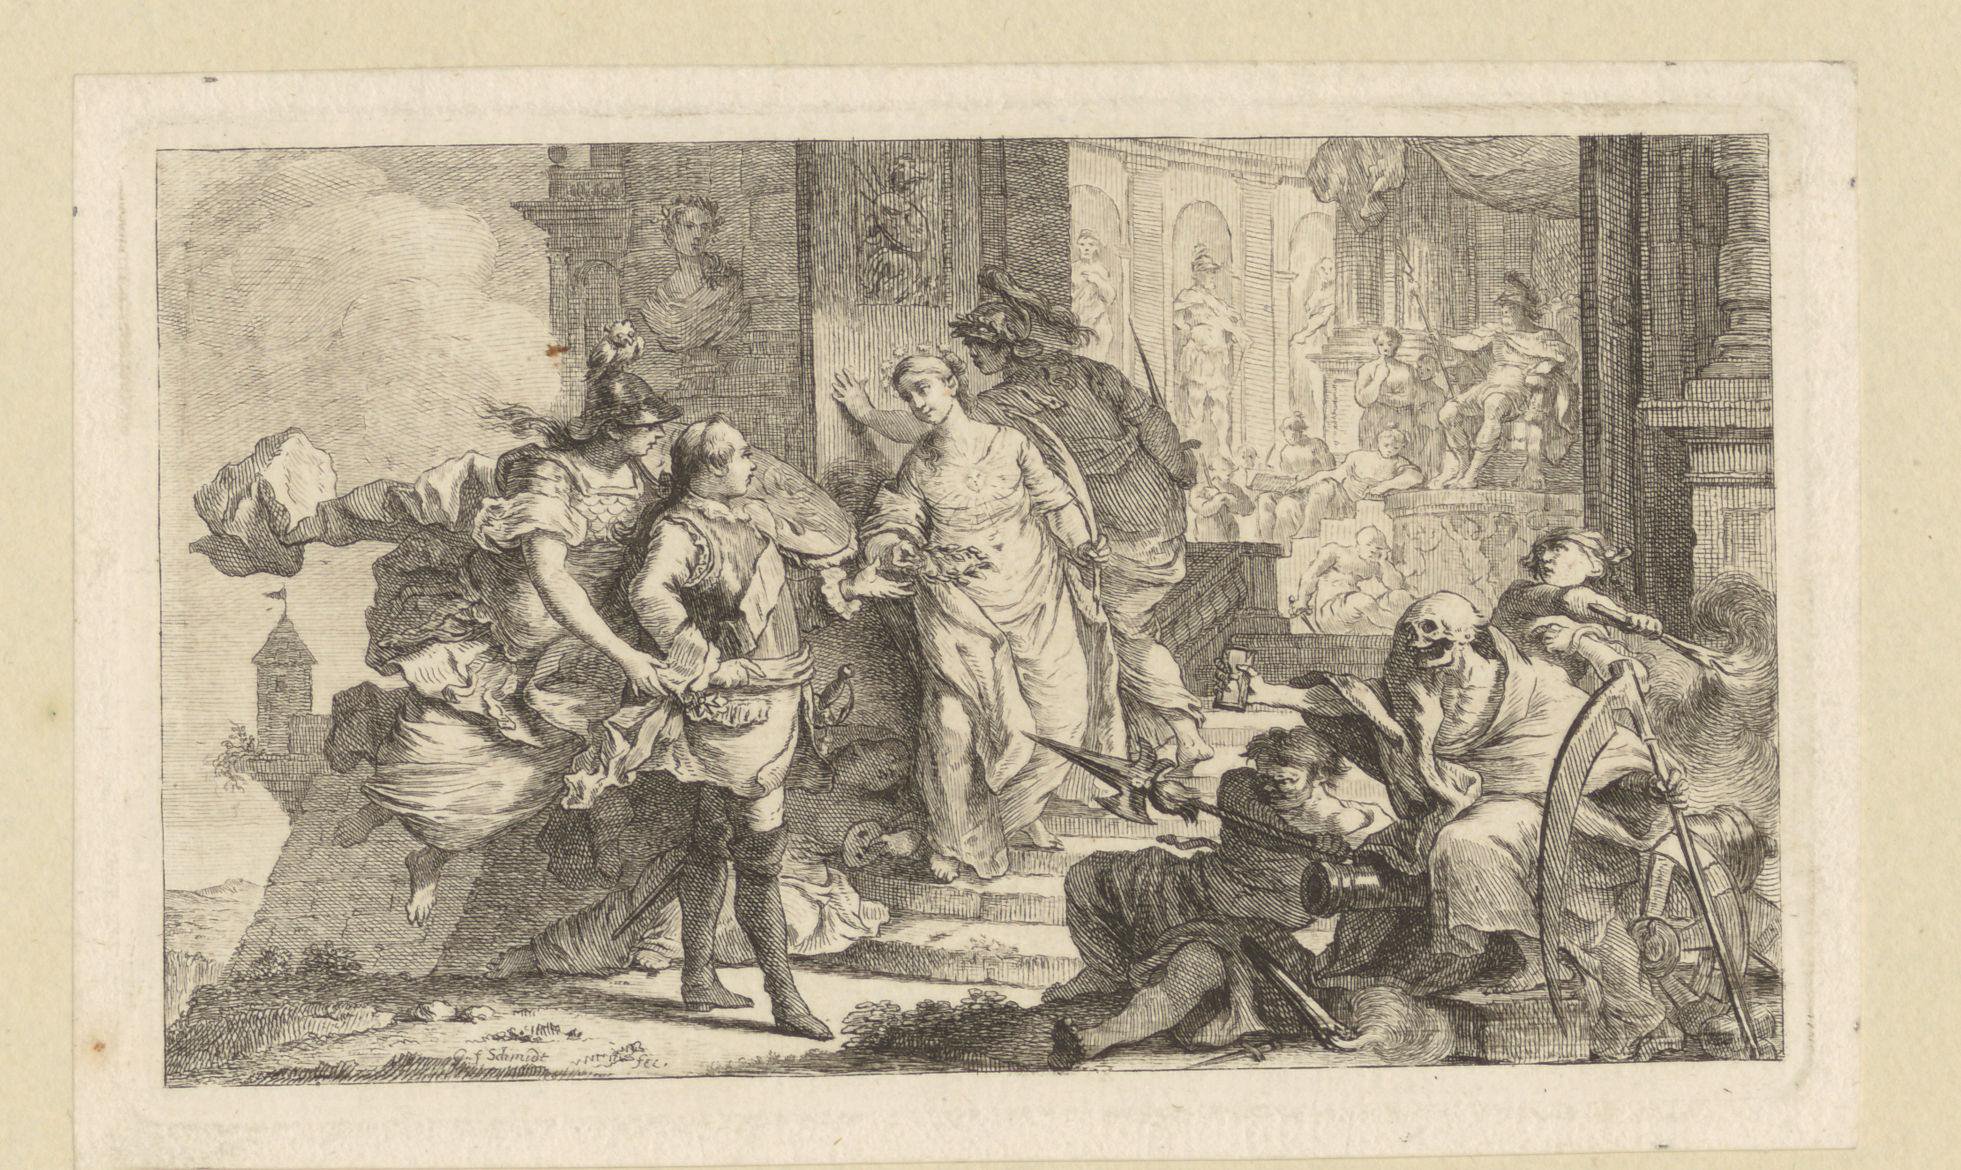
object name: book illustration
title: Held wordt door Bellona en Victoria naar de tempel van de roem geleid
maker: georg friedrich schmidt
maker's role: draughtsman, print maker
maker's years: 1712-1775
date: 1760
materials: paper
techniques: etching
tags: personification of hunger, 'fames'; 'fame' (ripa), men of name and fame, heroes, 'homines illustres', 'uomini famosi', 'victoria'; 'vittoria', 'vittoria navale', 'vittoria degl'antichi' (ripa), bellona (enyo)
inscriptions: collector's mark: Lugt 240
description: Prent ook gebruikt in: Frederik de Grote. Poësies diverses. Sanssouci, Frederik de Grote, 1760.